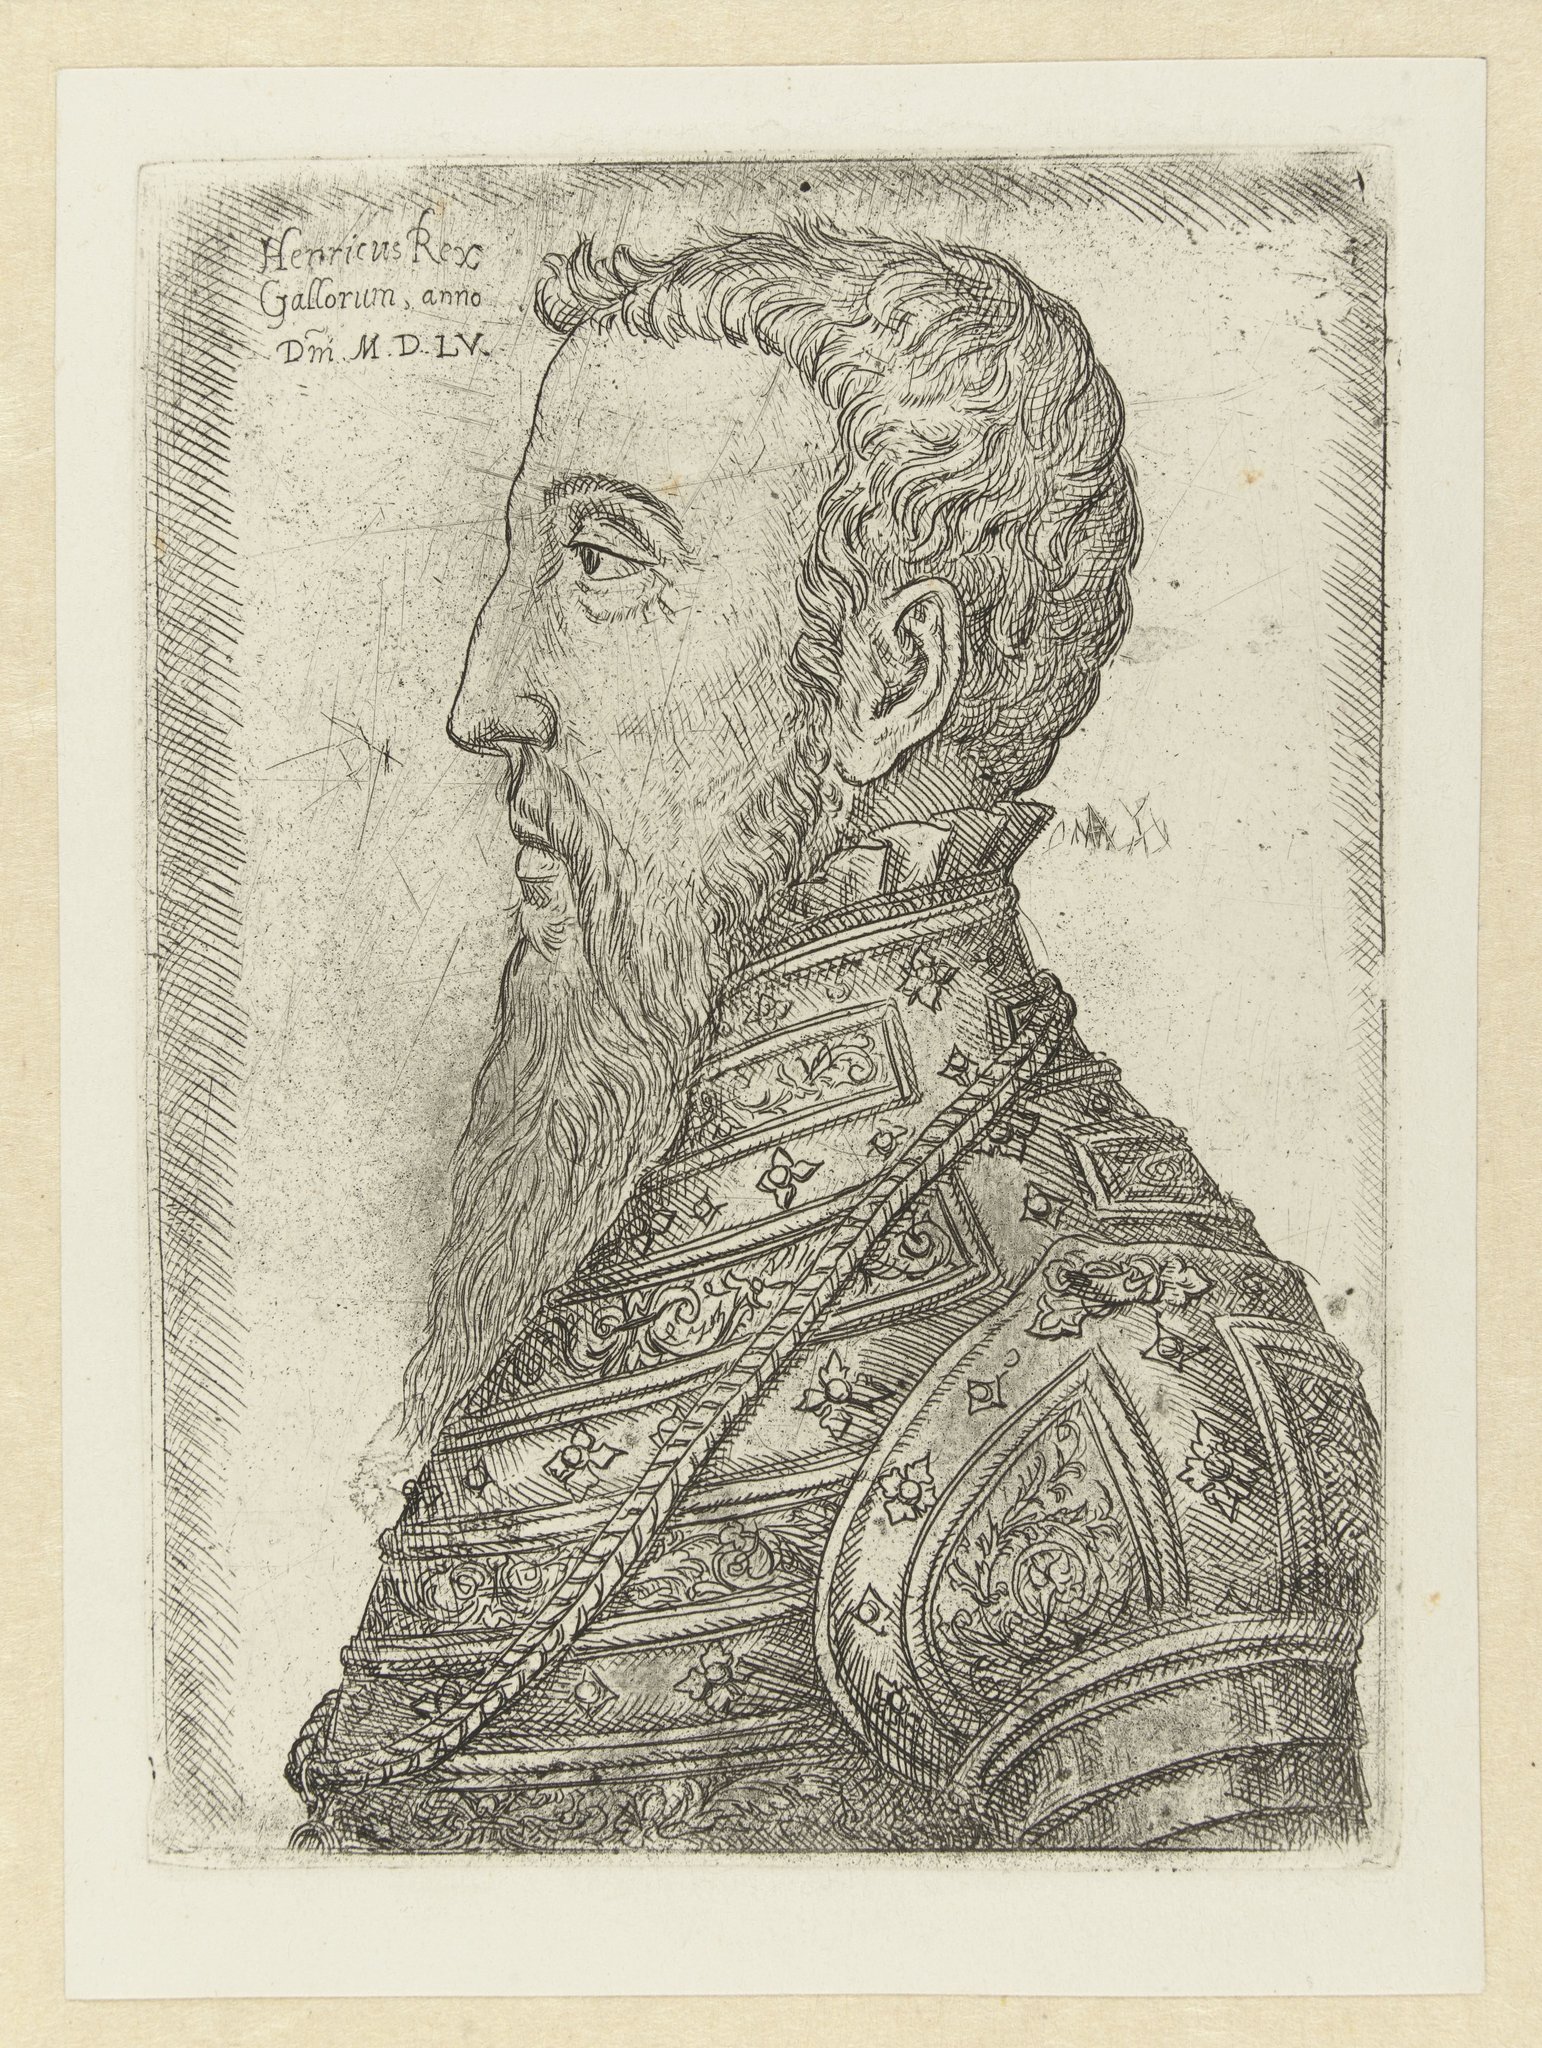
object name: print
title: Henricus Rex Gallorum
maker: jan cornelisz vermeyen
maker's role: draughtsman, painter, print maker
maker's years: 1500-1559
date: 1555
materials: paper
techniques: etching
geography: low countries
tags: hendrik ii (koning van frankrijk)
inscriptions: collector's mark: Lugt 2228a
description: Portret en profil van Hendrik II in harnas.